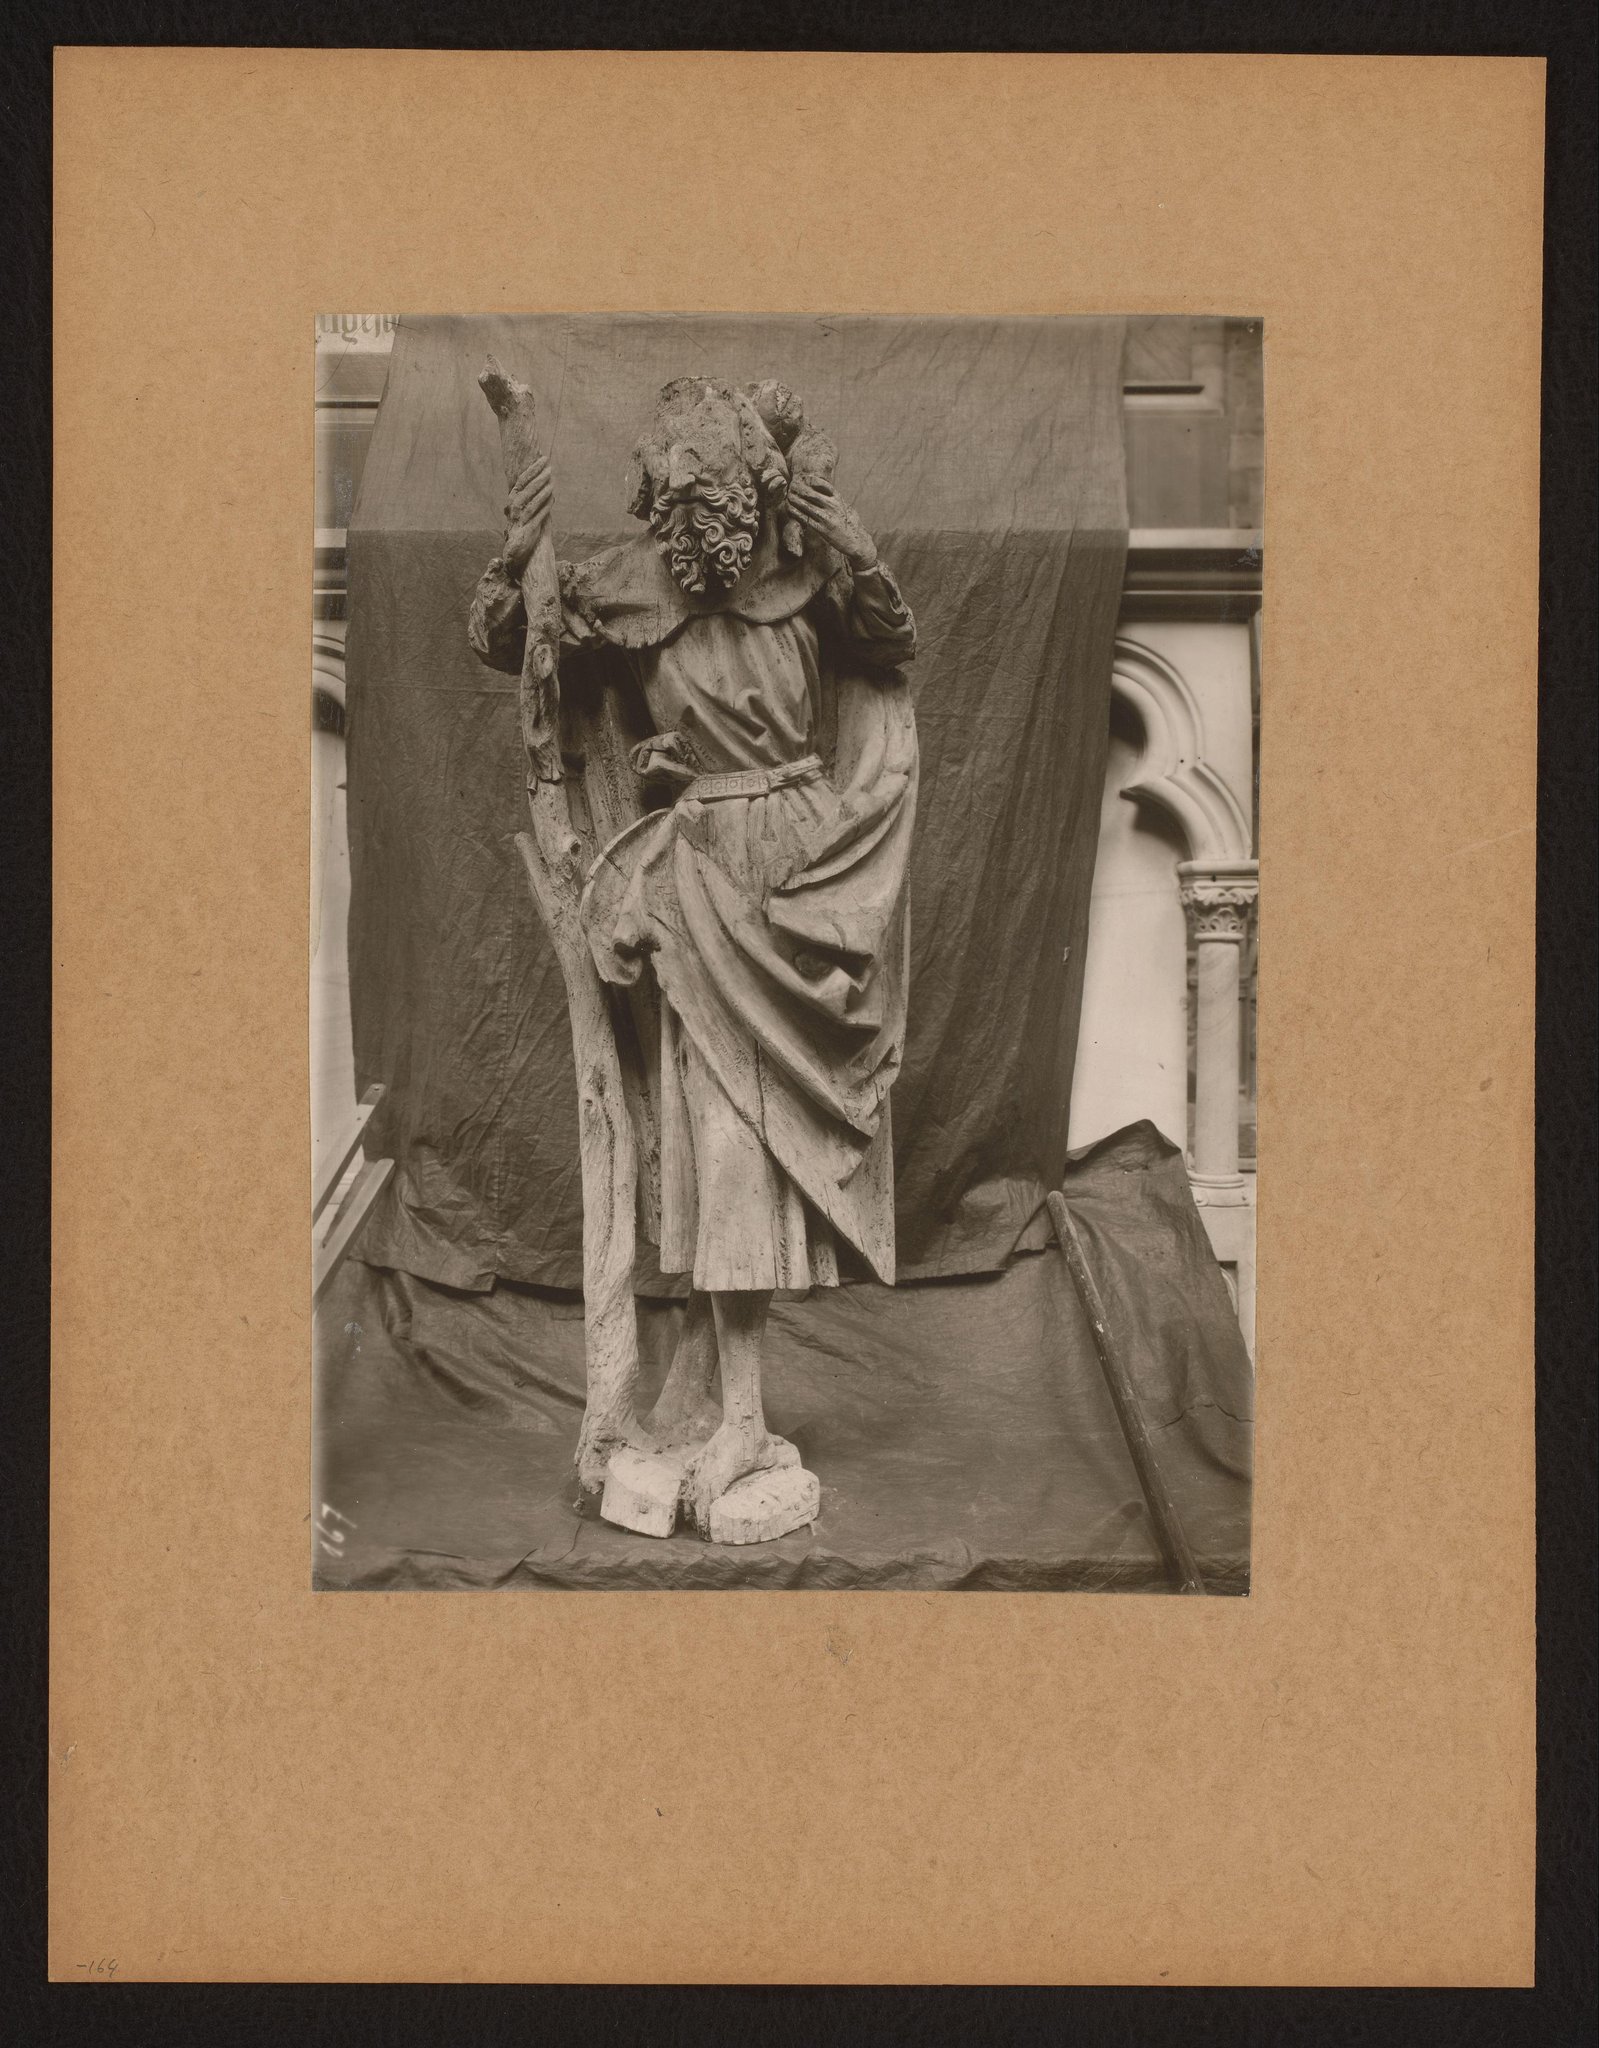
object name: album leaf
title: Domschatz, hl. Christophoes v. vorn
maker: Anonymous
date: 1900-1920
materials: paper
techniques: gelatin silver print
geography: bamberg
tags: interior of church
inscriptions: number: ‘167’